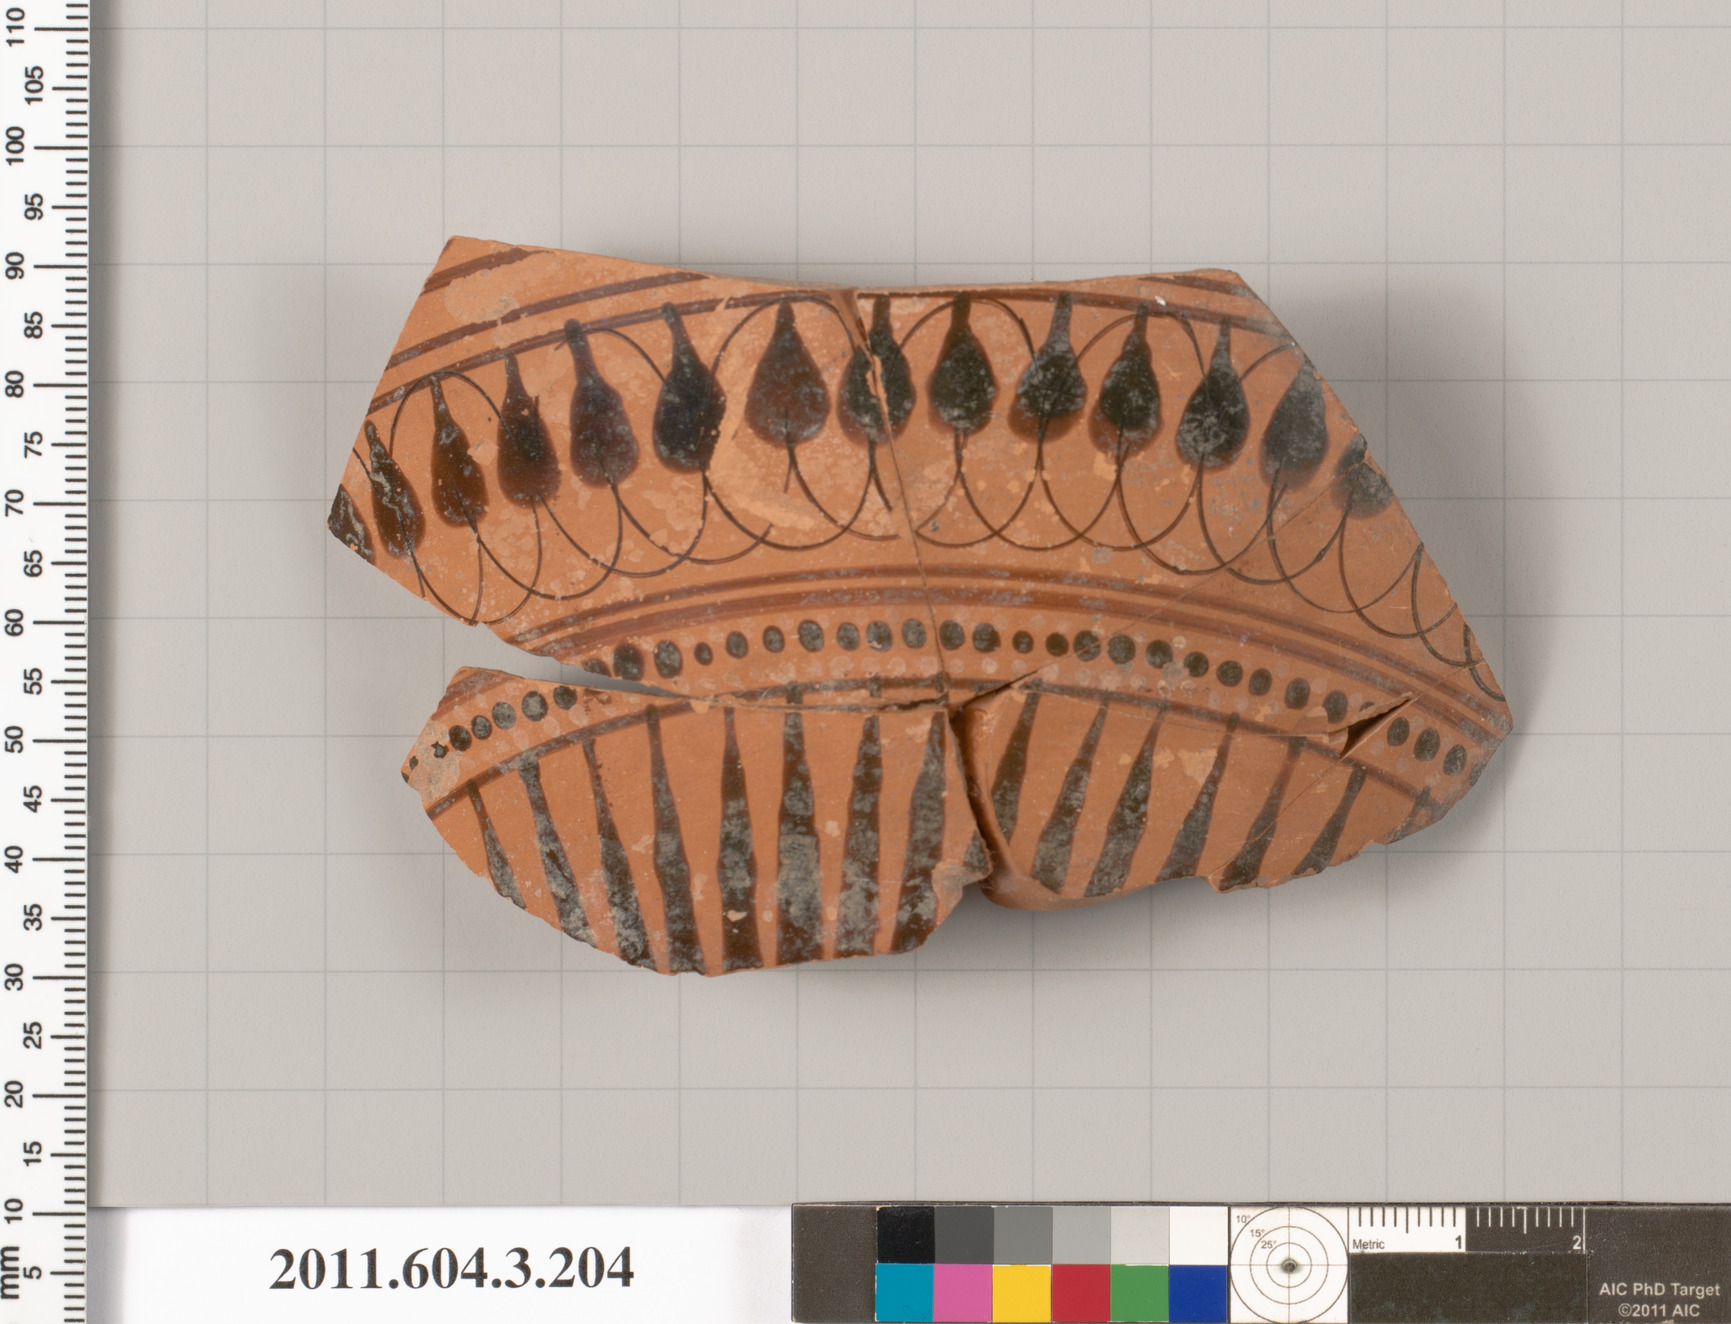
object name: neck amphora fragment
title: Terracotta fragment of a neck-amphora (jar)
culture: greek, attic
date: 525-501 BCE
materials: terracotta